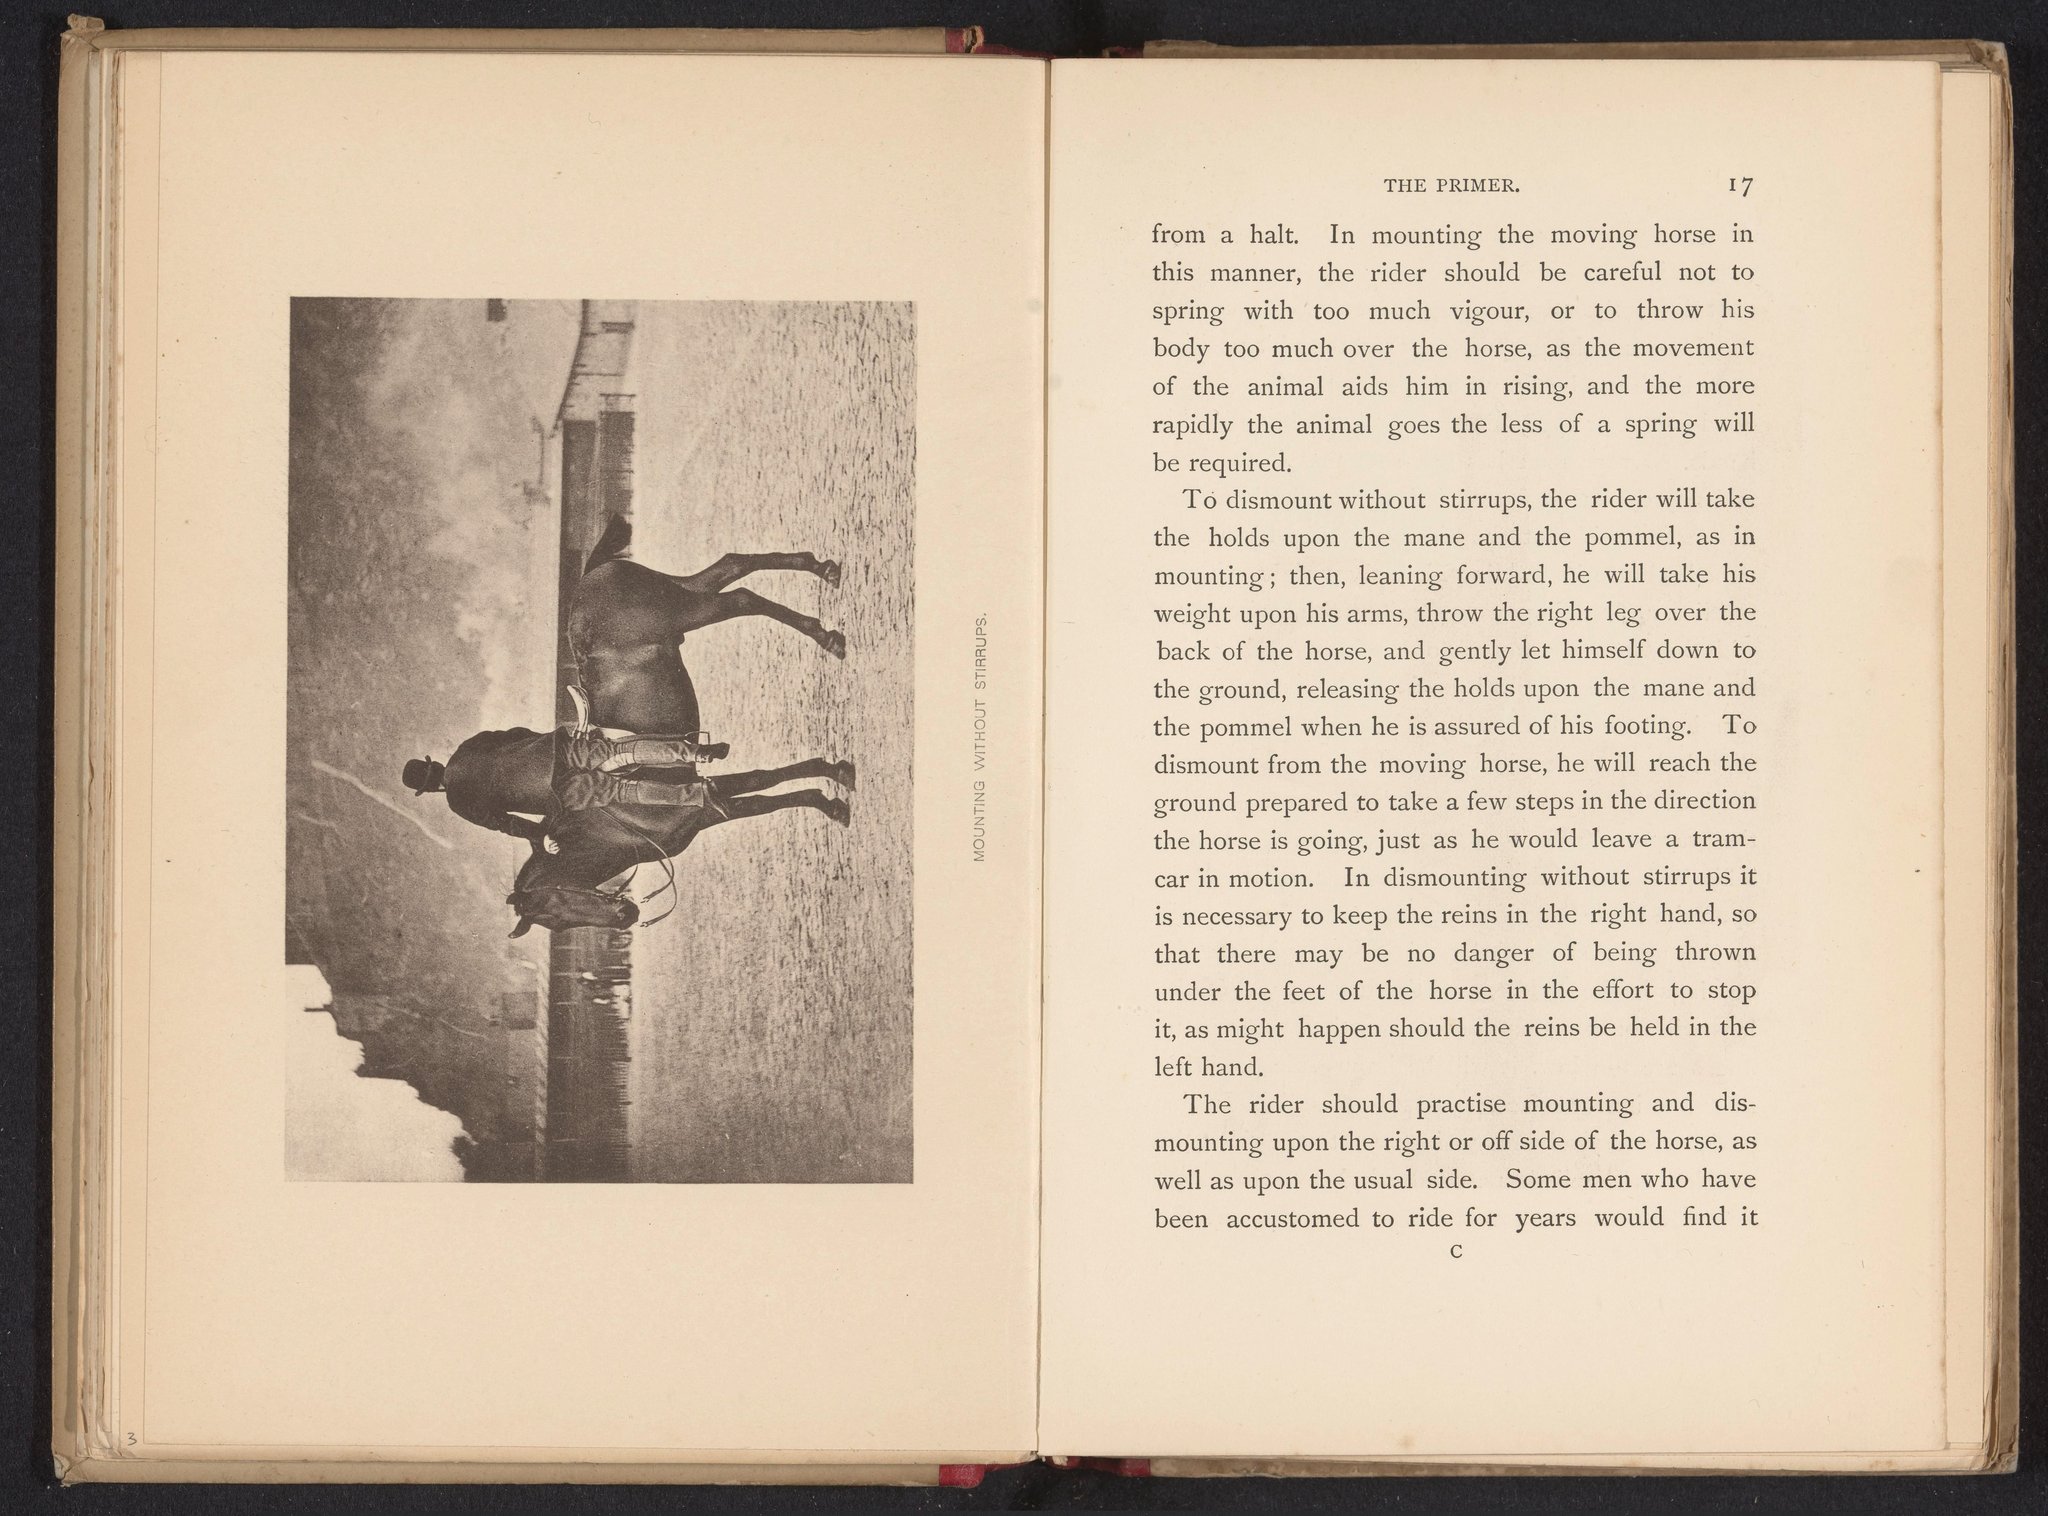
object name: page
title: Mounting without Stirrups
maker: Anonymous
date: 1879-1889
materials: paper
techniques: photograph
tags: riding a horse, ass, or mule; rider, horseman, head-gear: bowler hat, horse